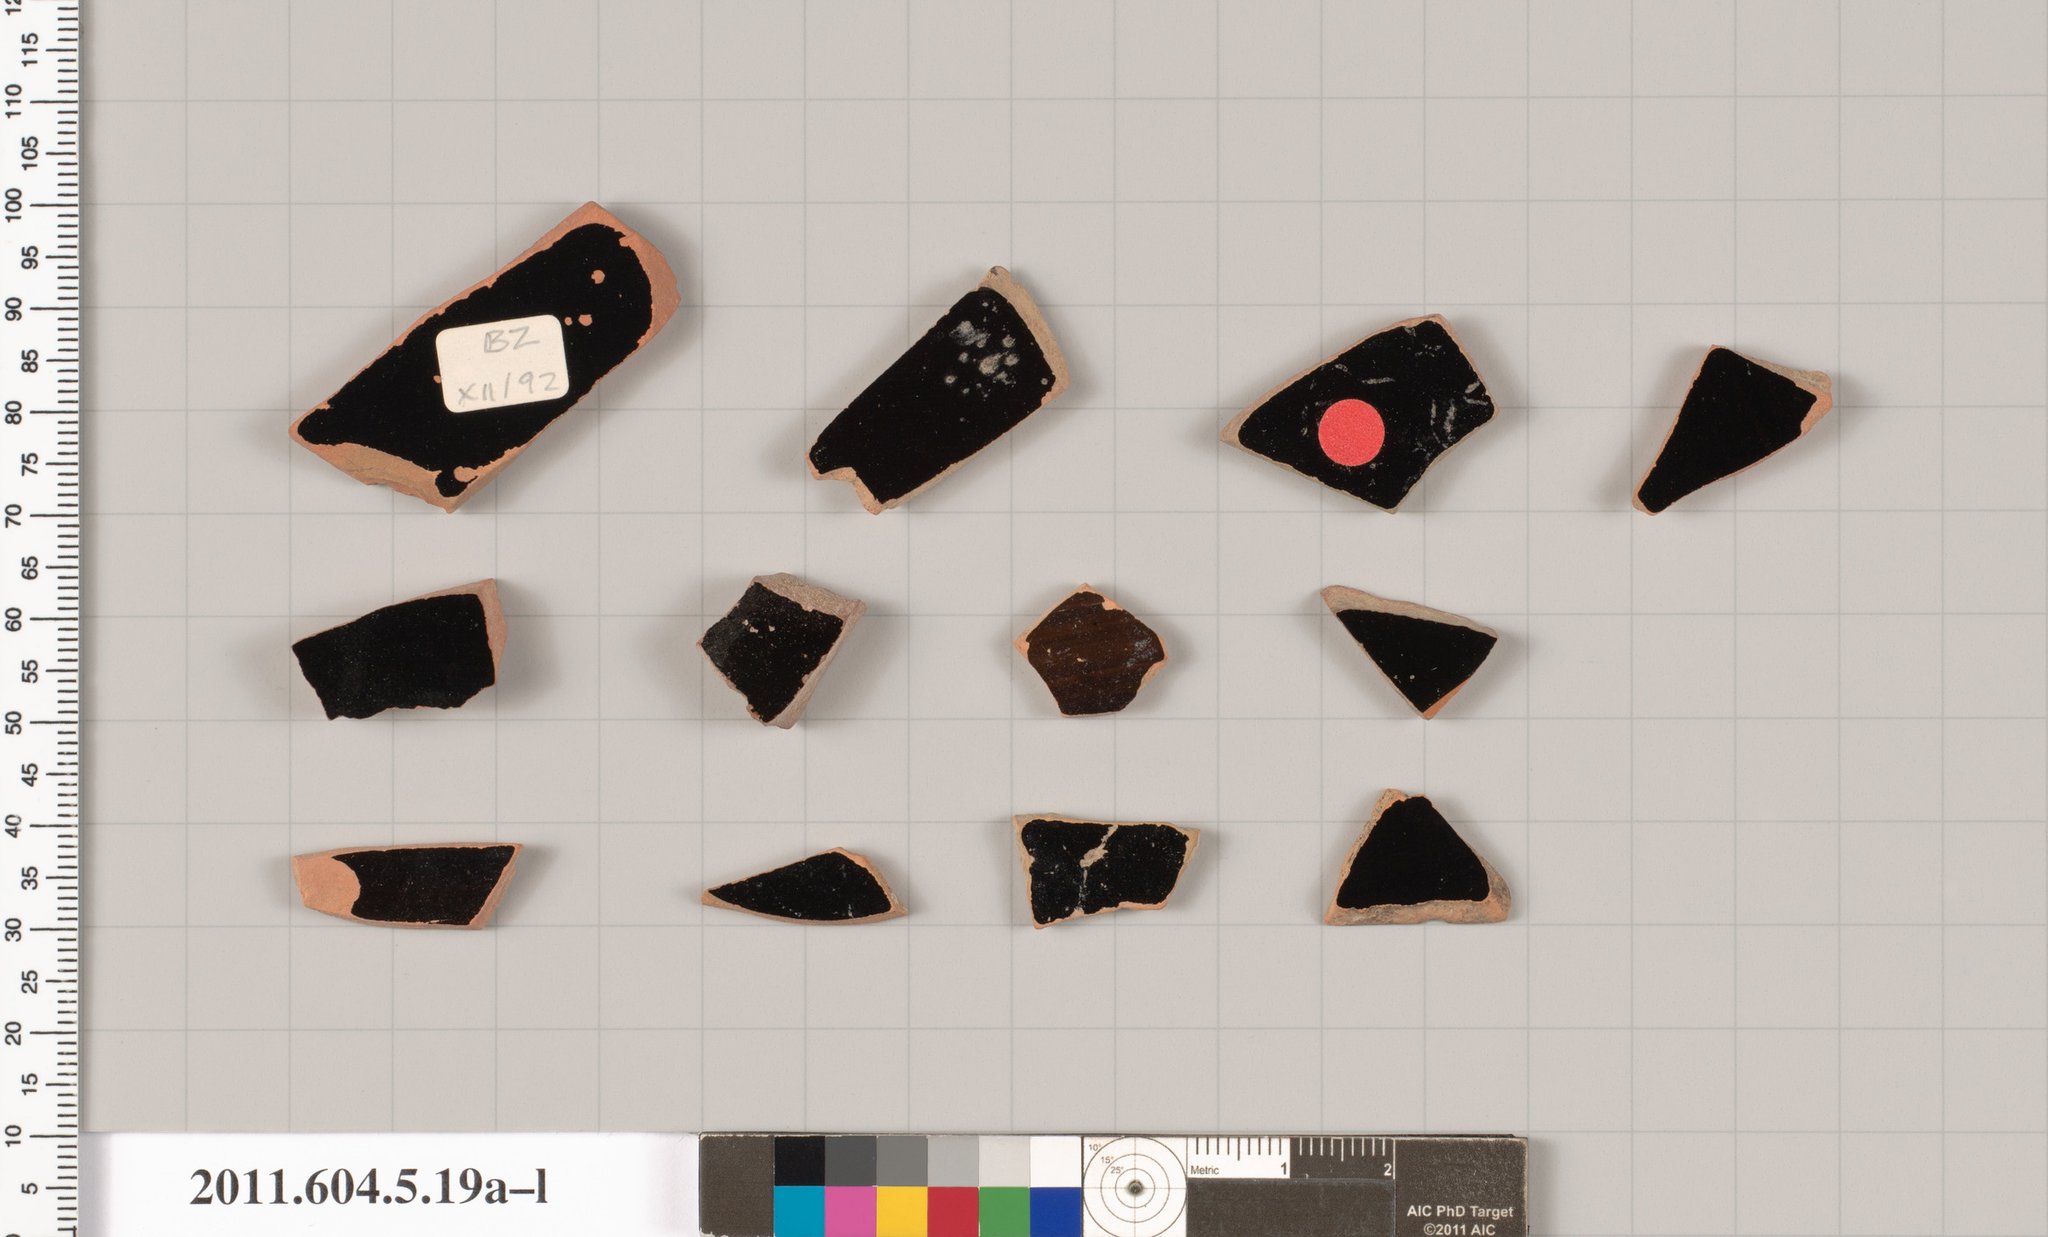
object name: kylix fragment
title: Terracotta fragments of kylikes (drinking cups)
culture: greek, attic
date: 475-451 BCE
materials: terracotta